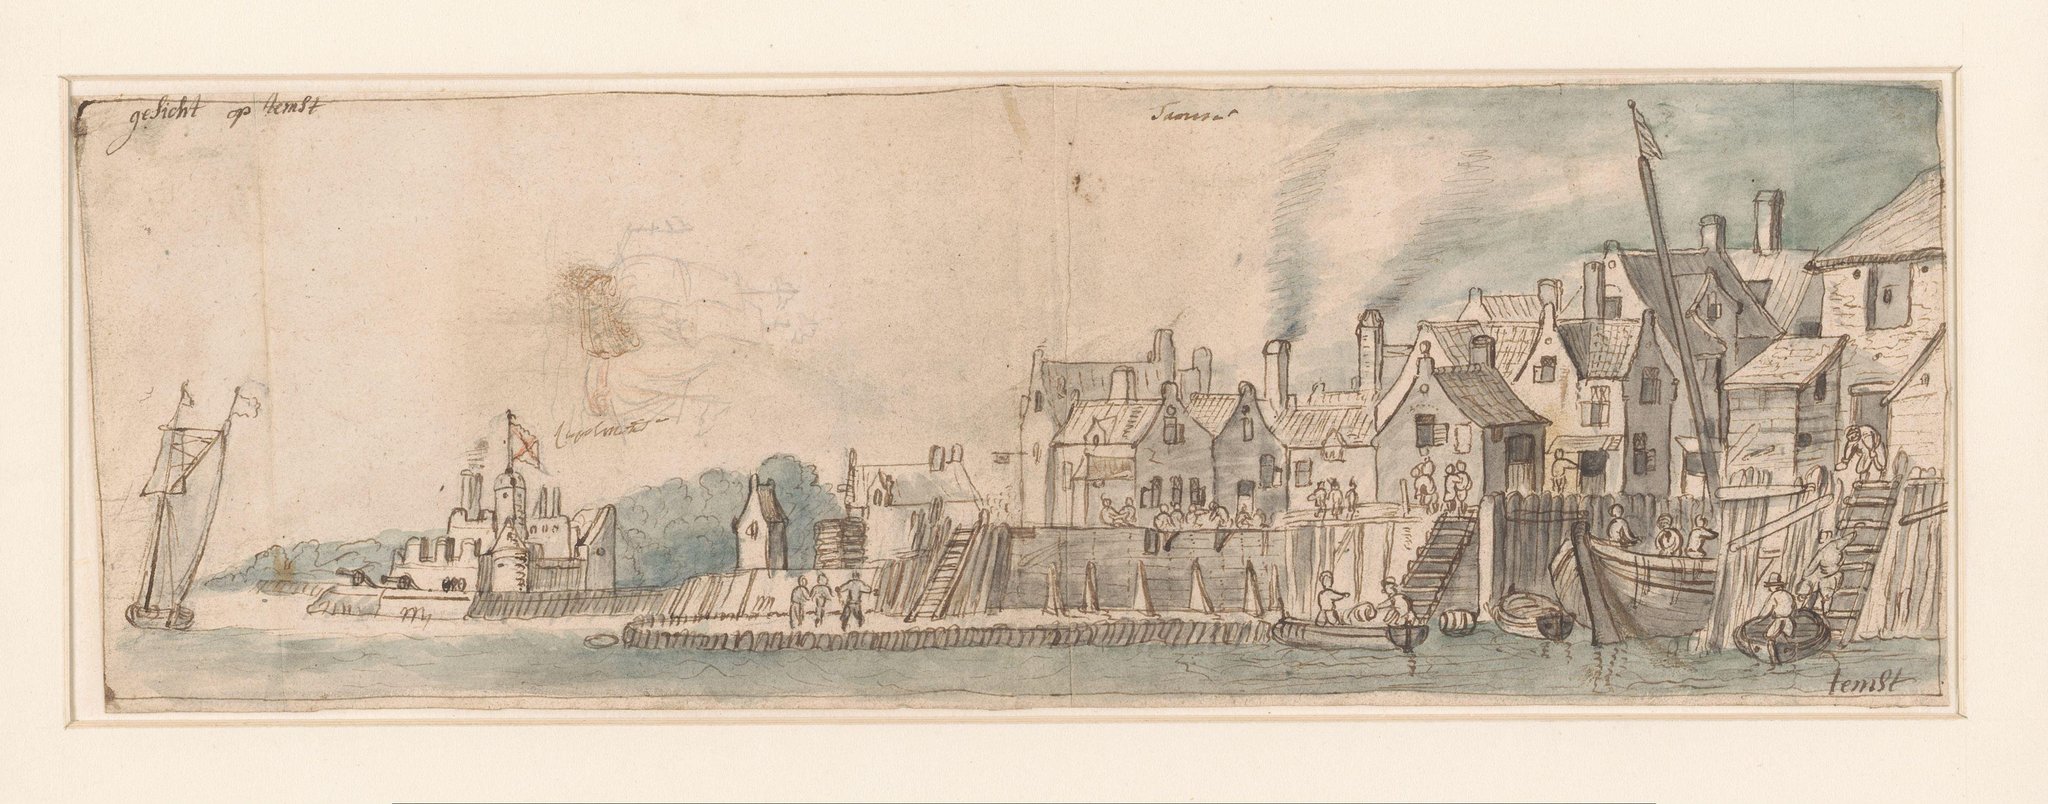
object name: drawing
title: Gesicht op Temst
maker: Anonymous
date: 1700-1799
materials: ink, paper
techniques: brush, drawing, pen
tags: sailing-ship, sailing-boat, quay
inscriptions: annotation: ‘no. 8’